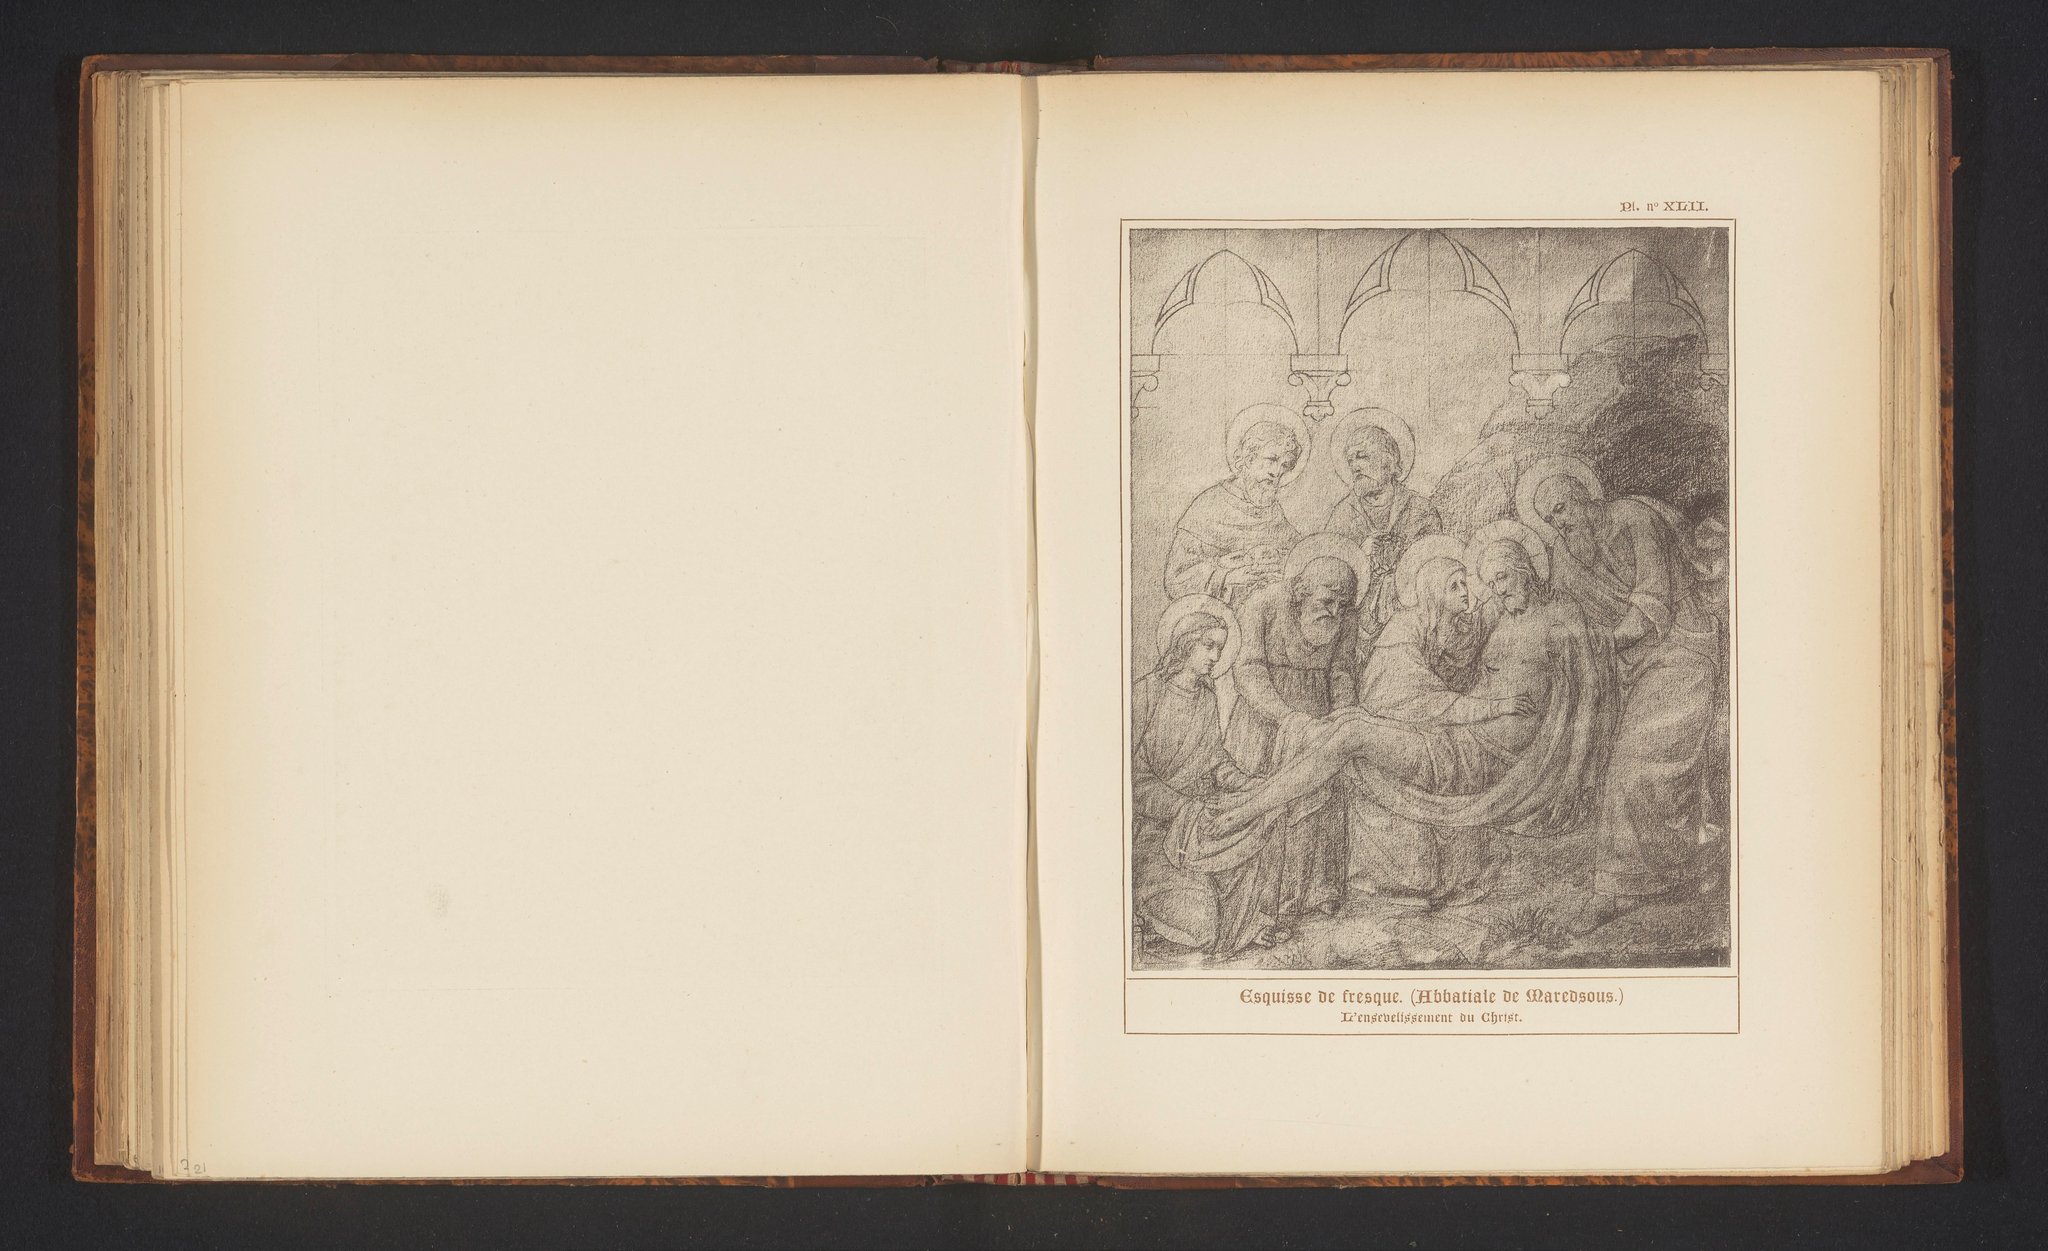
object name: reproduction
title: Esquisse de fresque. (Abbatiale de Maredsous)/ l'ensevelissement du Christ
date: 1891-1896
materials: paper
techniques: photograph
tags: christ's entombment (possibly by angels)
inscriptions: number: ‘Pl. no XLII.’